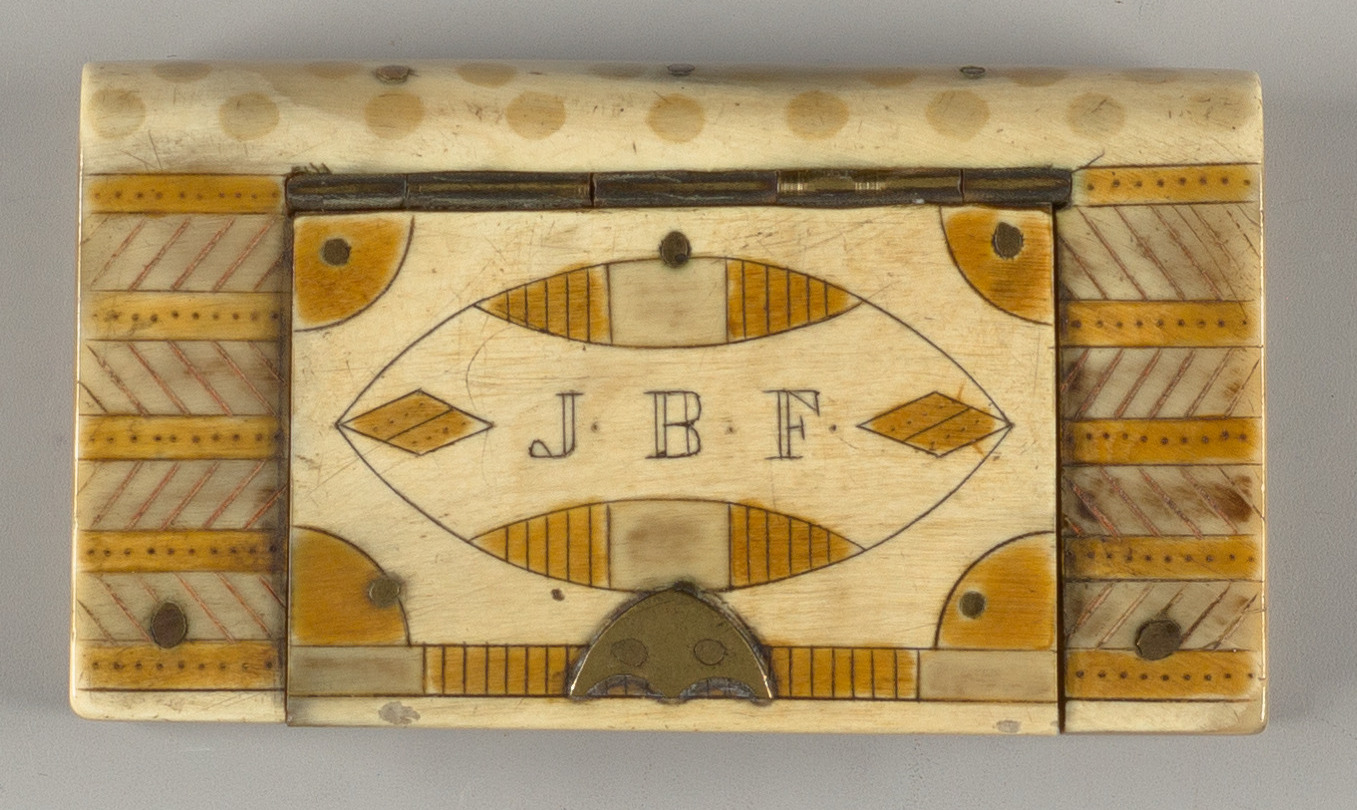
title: Snuff box in book form, inscribed "J. B. F."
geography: europe